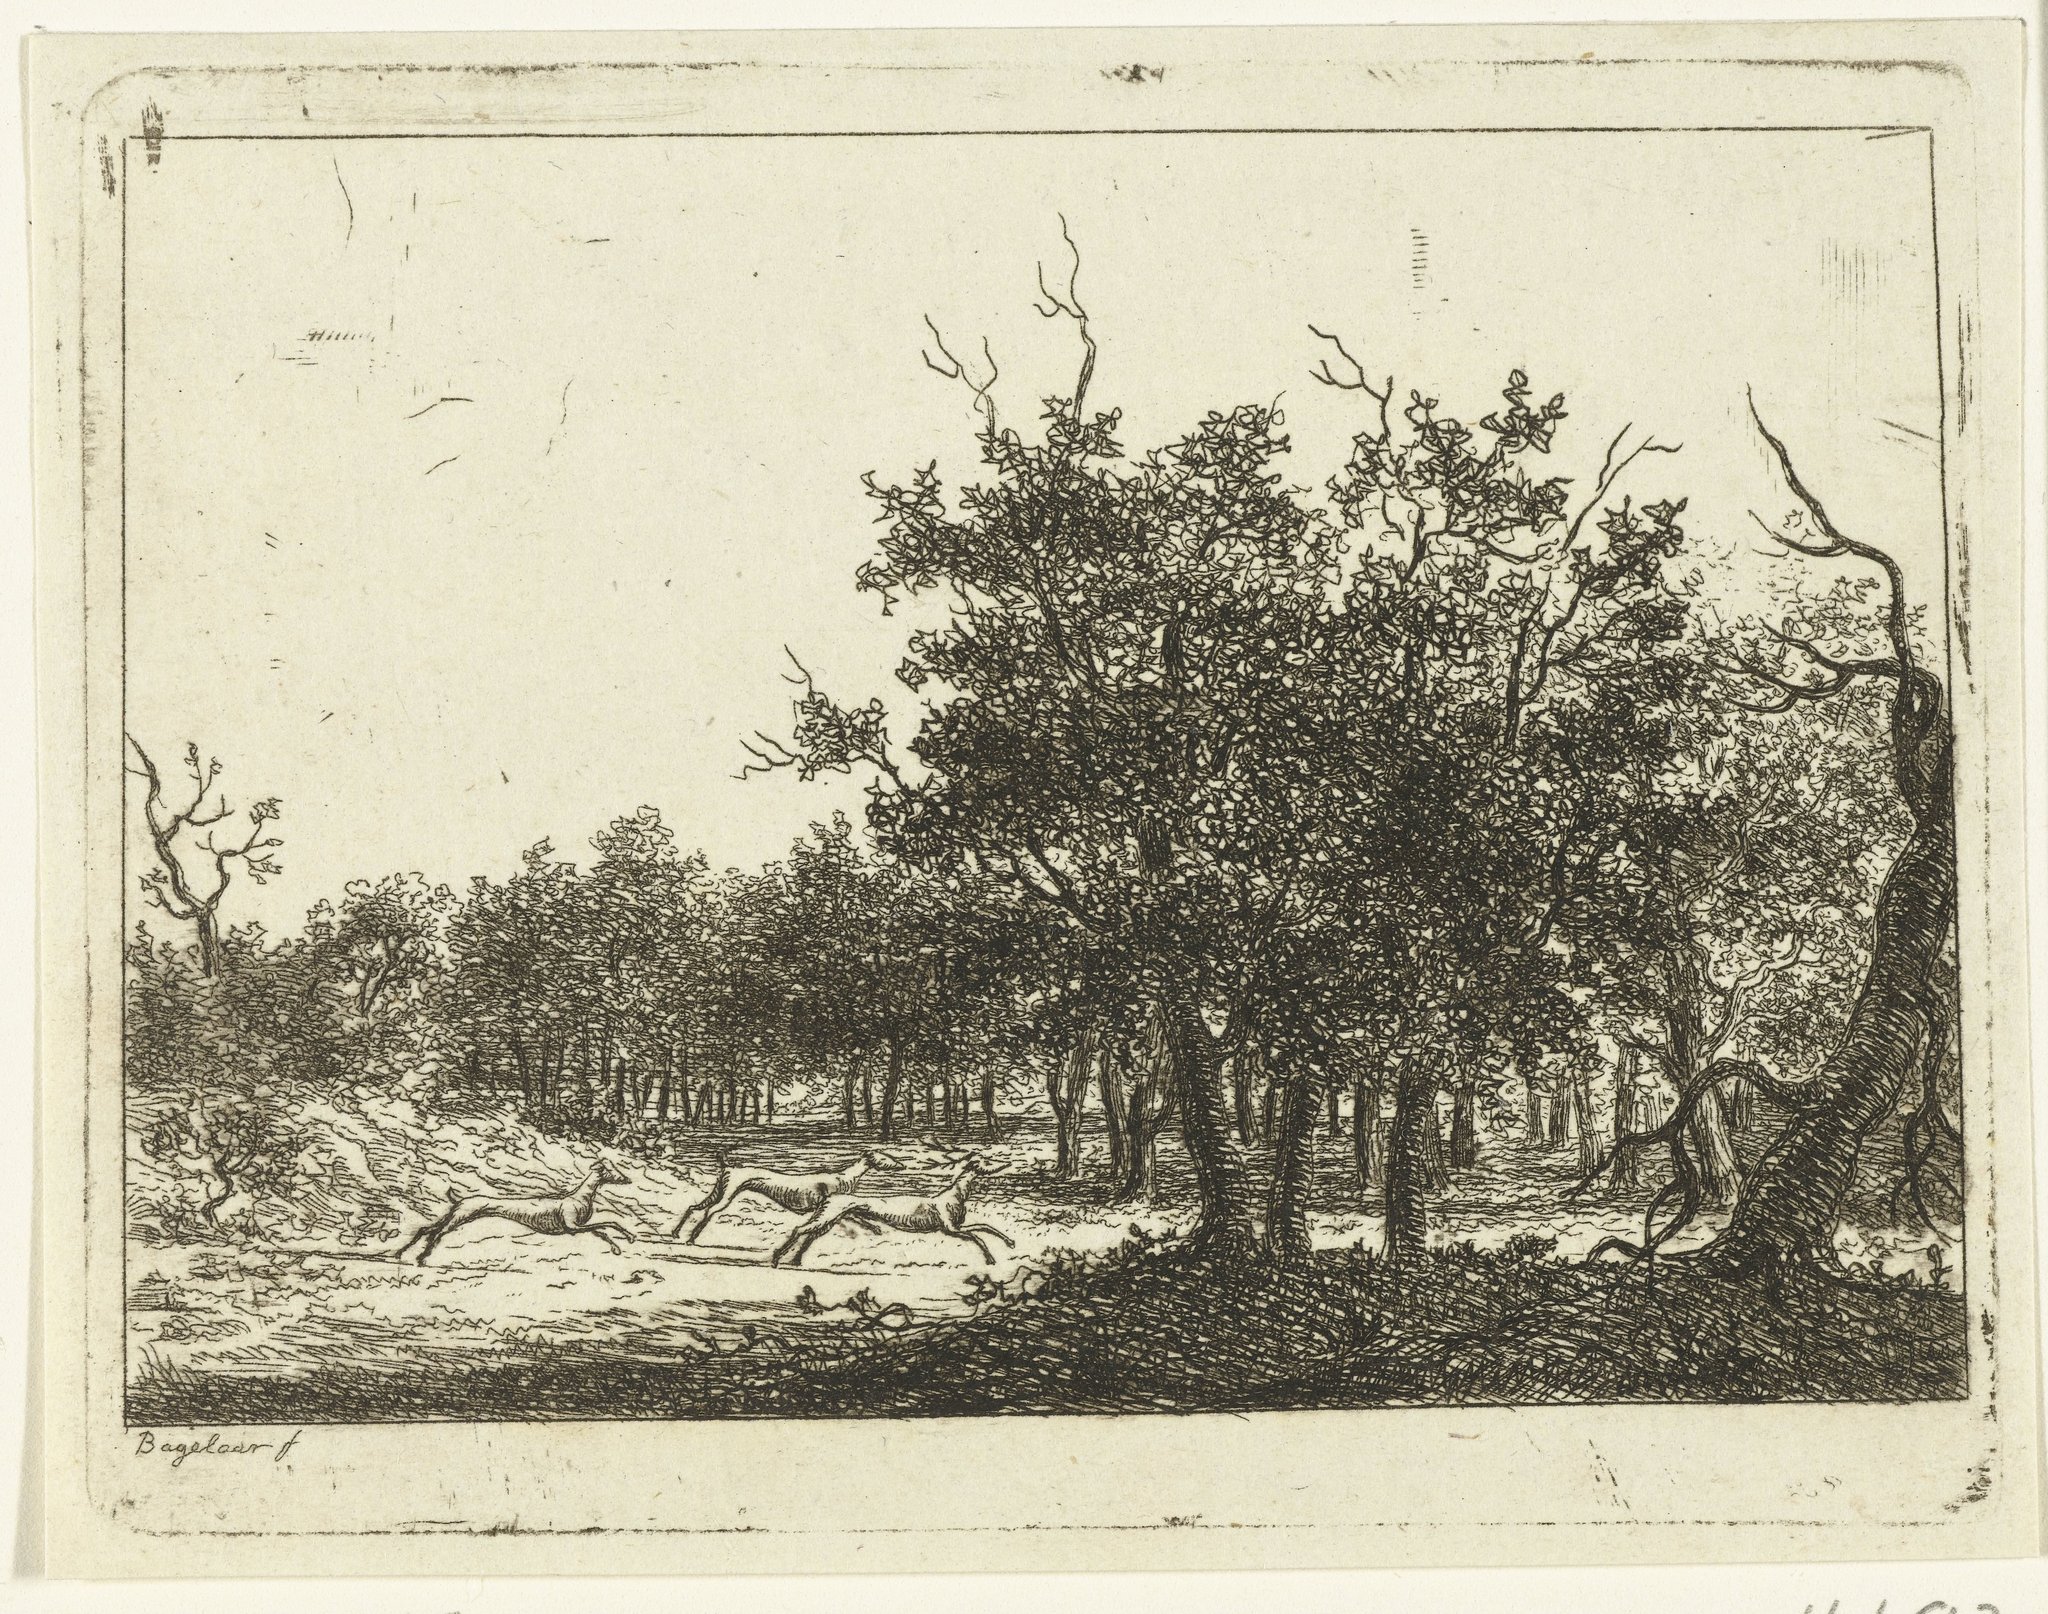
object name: print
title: Landschap met drie herten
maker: ernst willem jan bagelaar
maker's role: draughtsman, print maker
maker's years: 1775-1837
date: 1798-1837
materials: paper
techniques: etching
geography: netherlands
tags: hoofed animals: deer, landscapes in the temperate zone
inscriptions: collector's mark: Lugt 2228